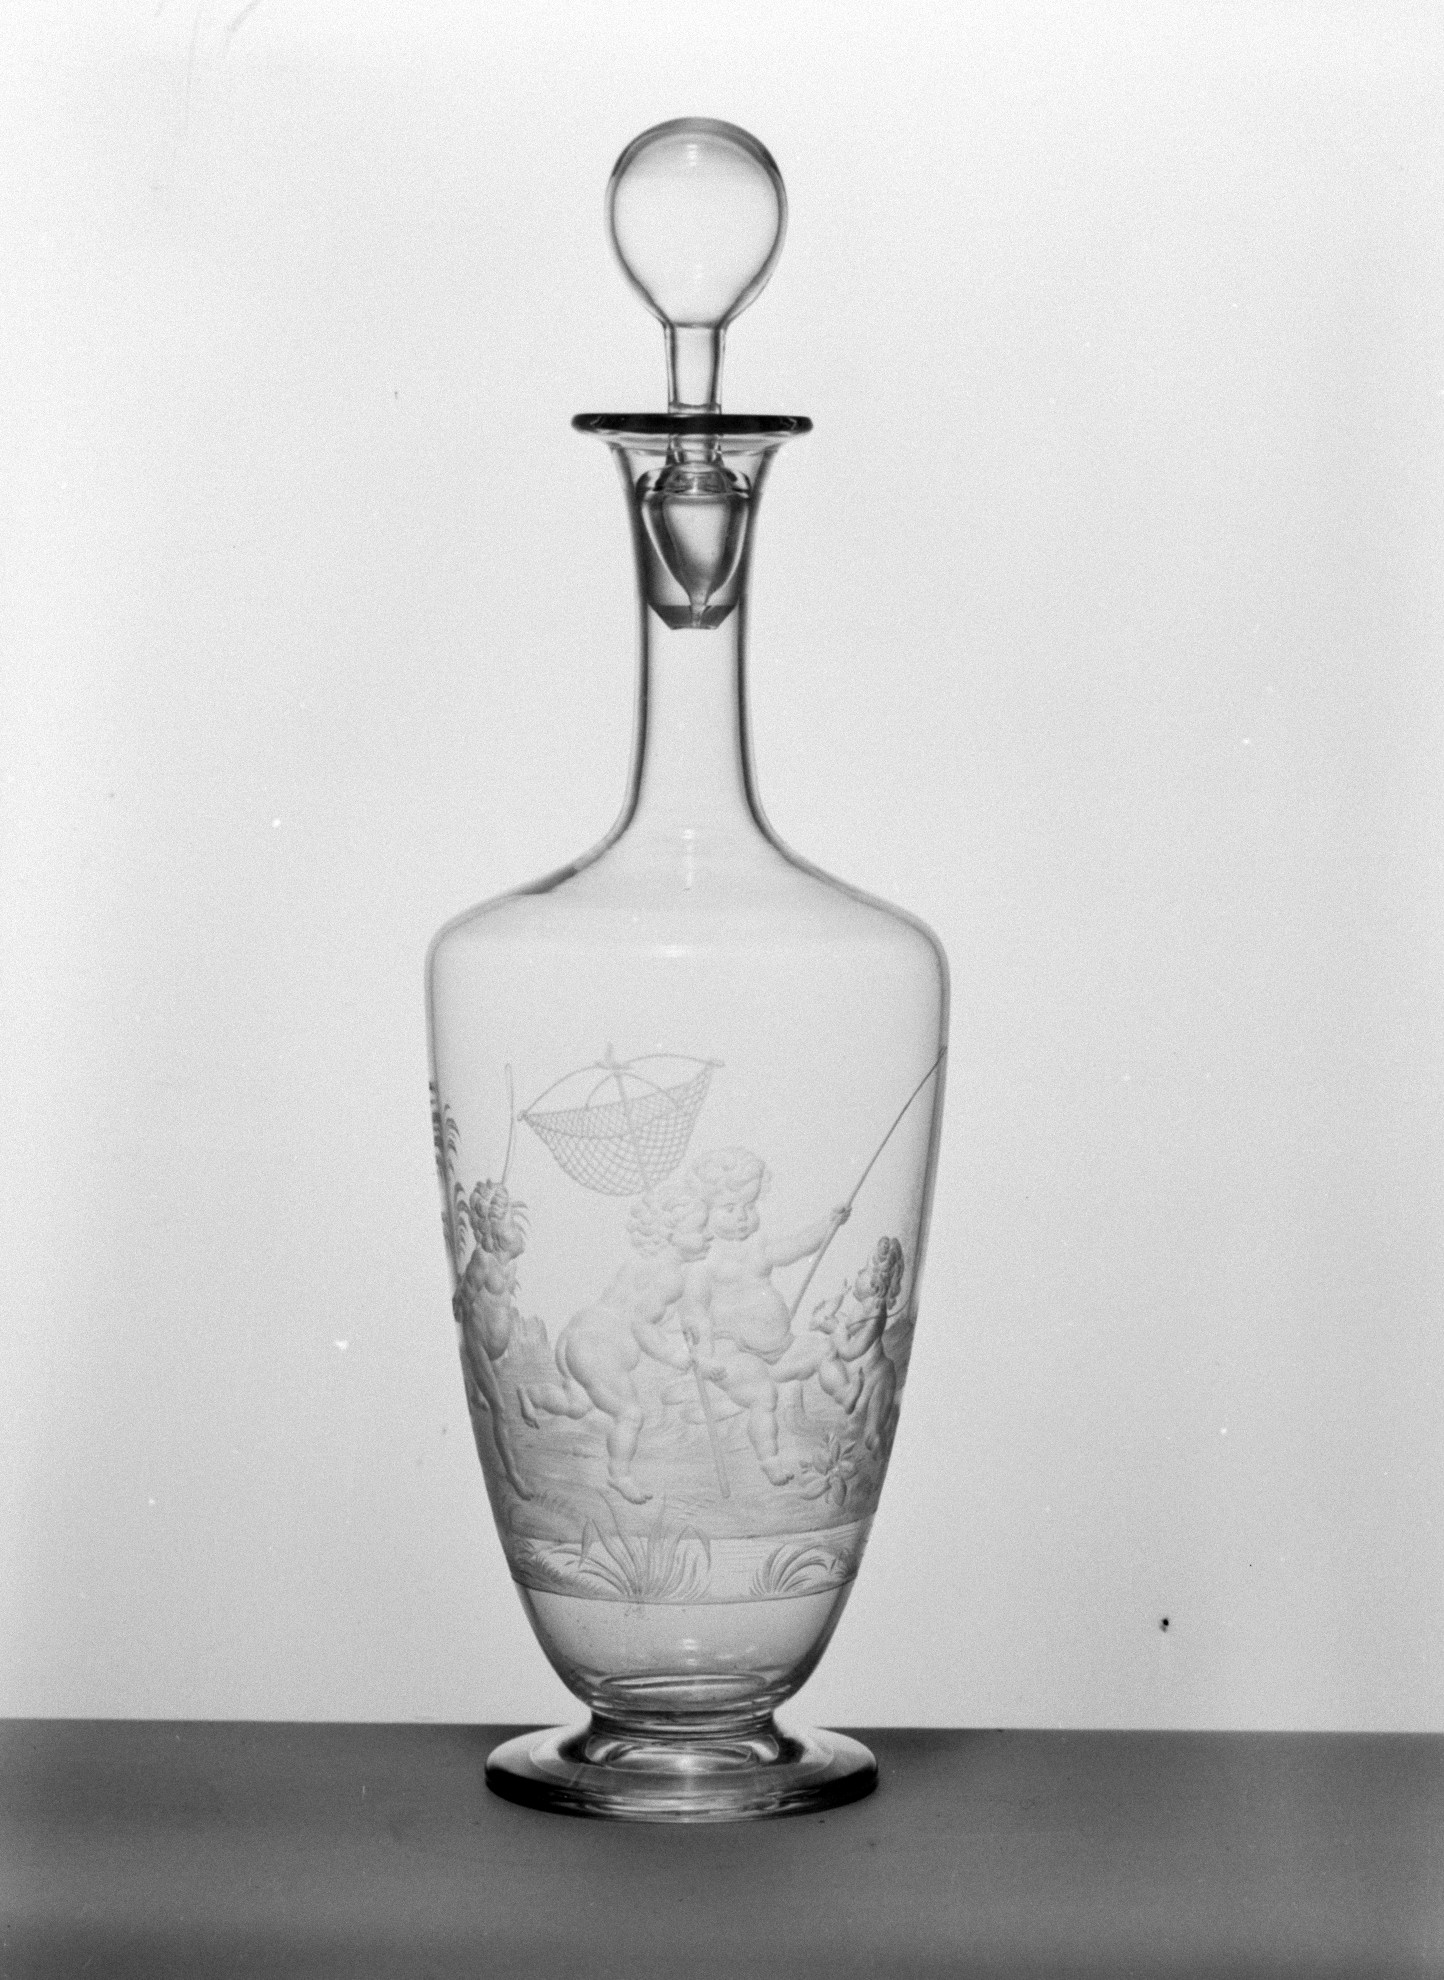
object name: decanter with stopper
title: Decanter with scene of children fishing (Summer) (one of a pair)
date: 1870-1880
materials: glass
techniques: engraving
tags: boys,fishing